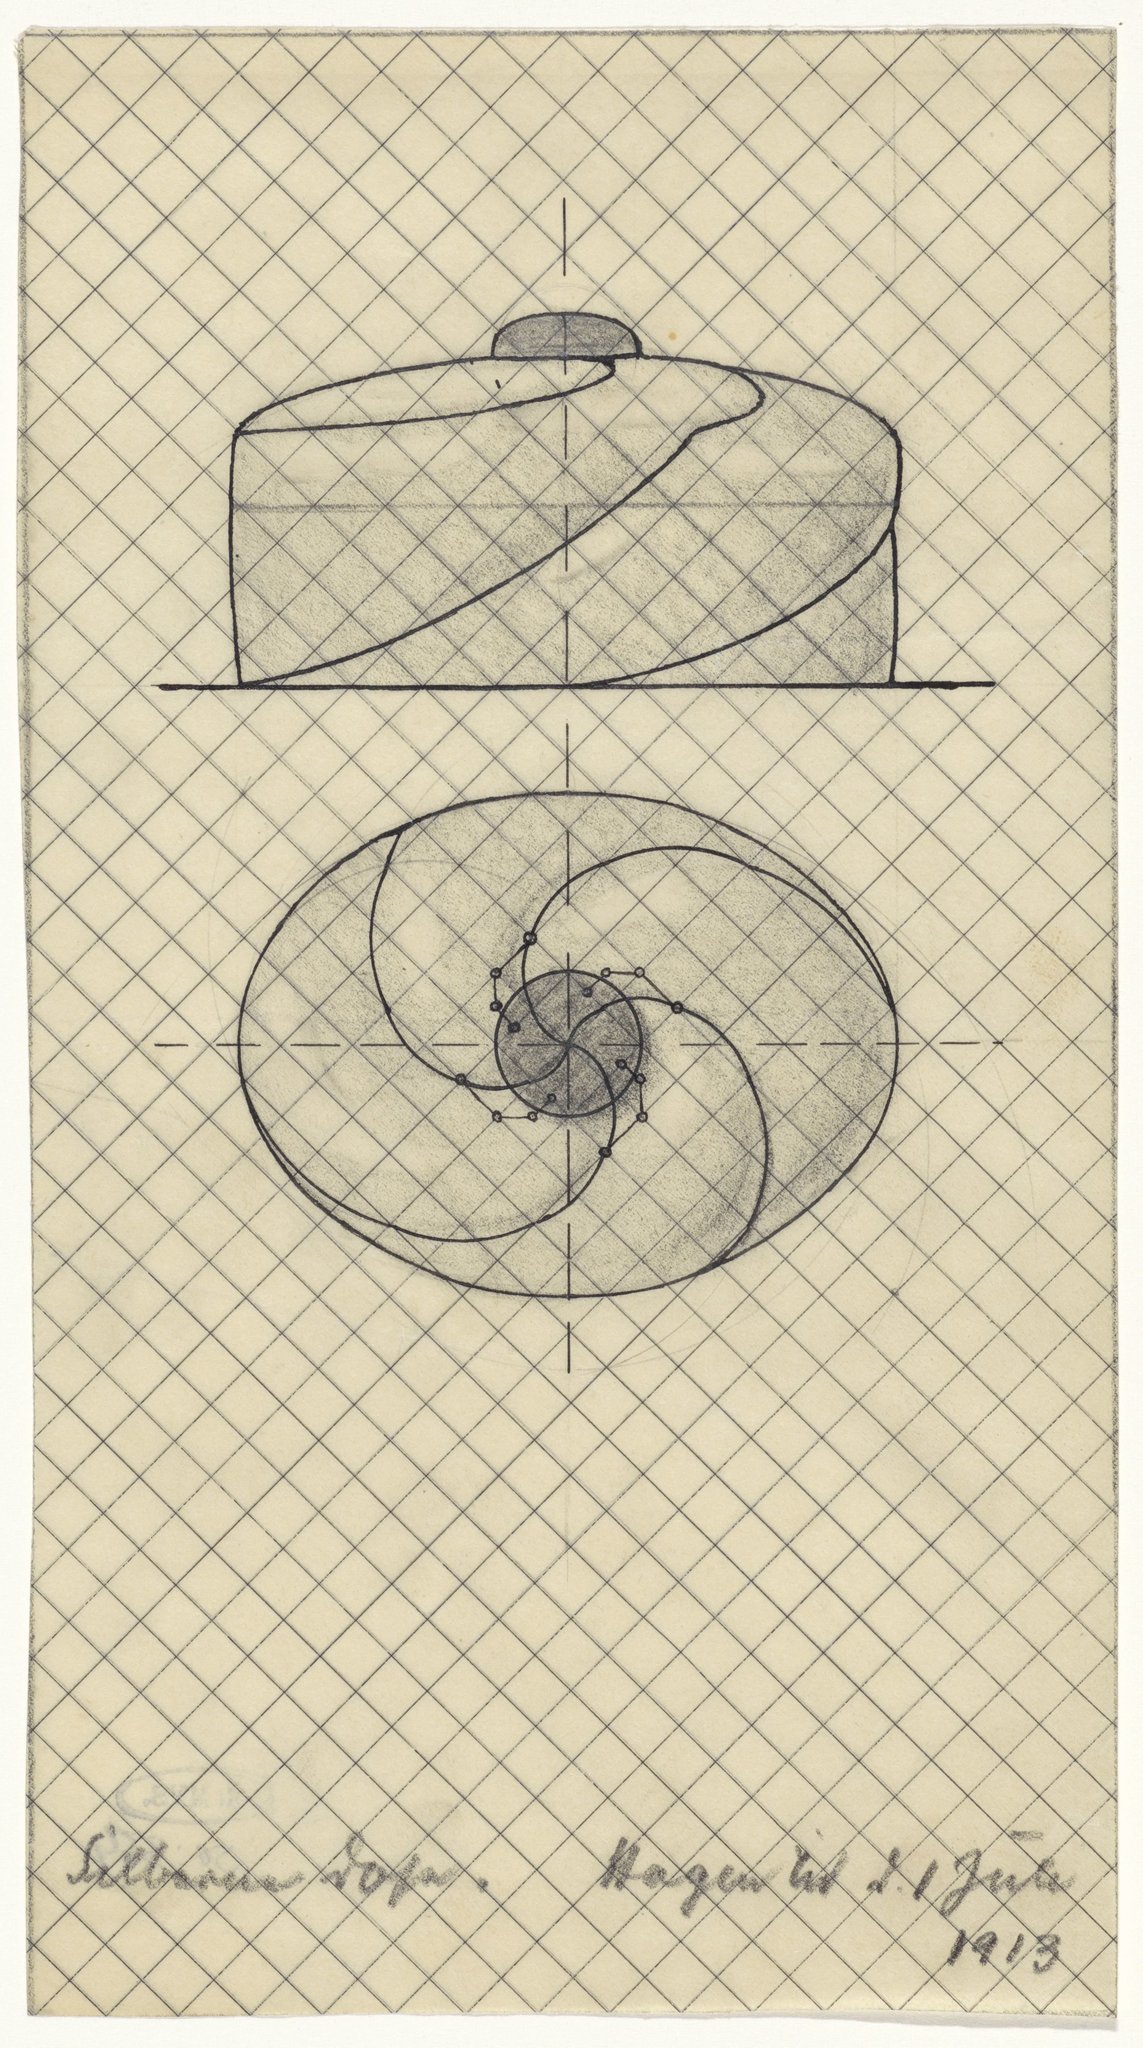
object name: drawing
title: Ontwerpen voor een zilveren doosje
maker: mathieu lauweriks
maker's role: designer, draughtsman, print maker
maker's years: 1864-1932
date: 1907-1913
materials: ink, pencil, paper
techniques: pen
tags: jewel-box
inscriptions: date: ‘Juli 1913’